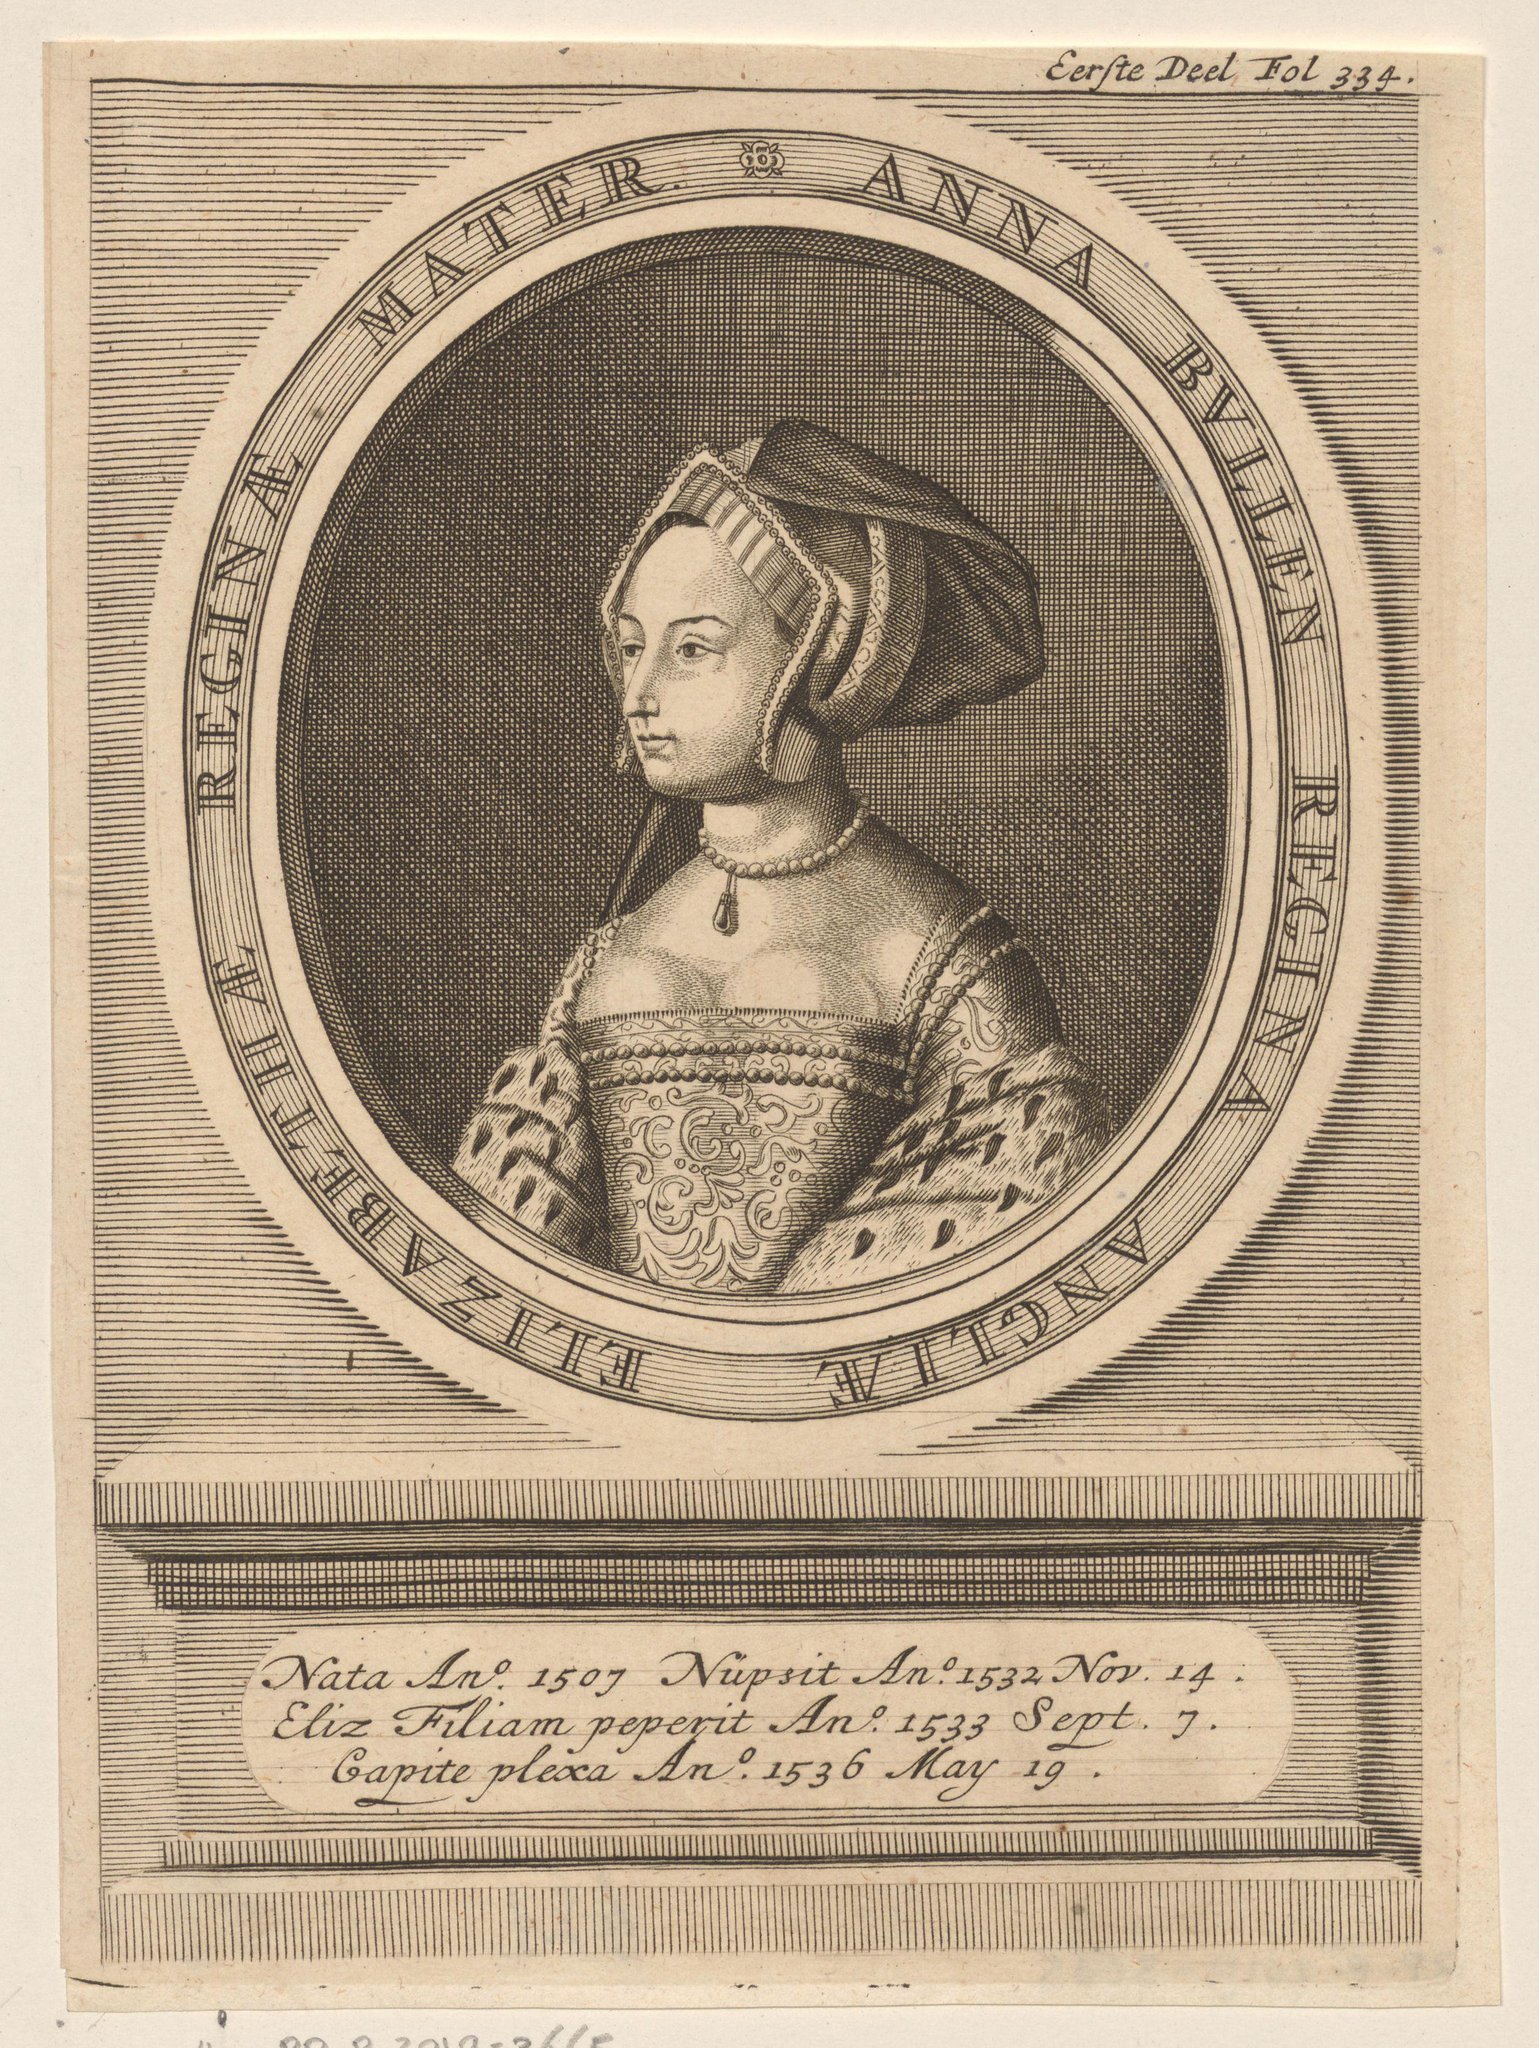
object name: book illustration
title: Portret van Anna Boleyn, koningin van Engeland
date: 1686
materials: paper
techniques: engraving, etching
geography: amsterdam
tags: historical persons - bb - woman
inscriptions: inscription: ‘621’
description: Prent uit: Burnet, Gilbert. Historie van de reformatie der kerke van Engeland. Amsterdam: Jan Claesz Hoorn en Aart Dircksz Oossaan, 1686, dl. 1, p. 334.